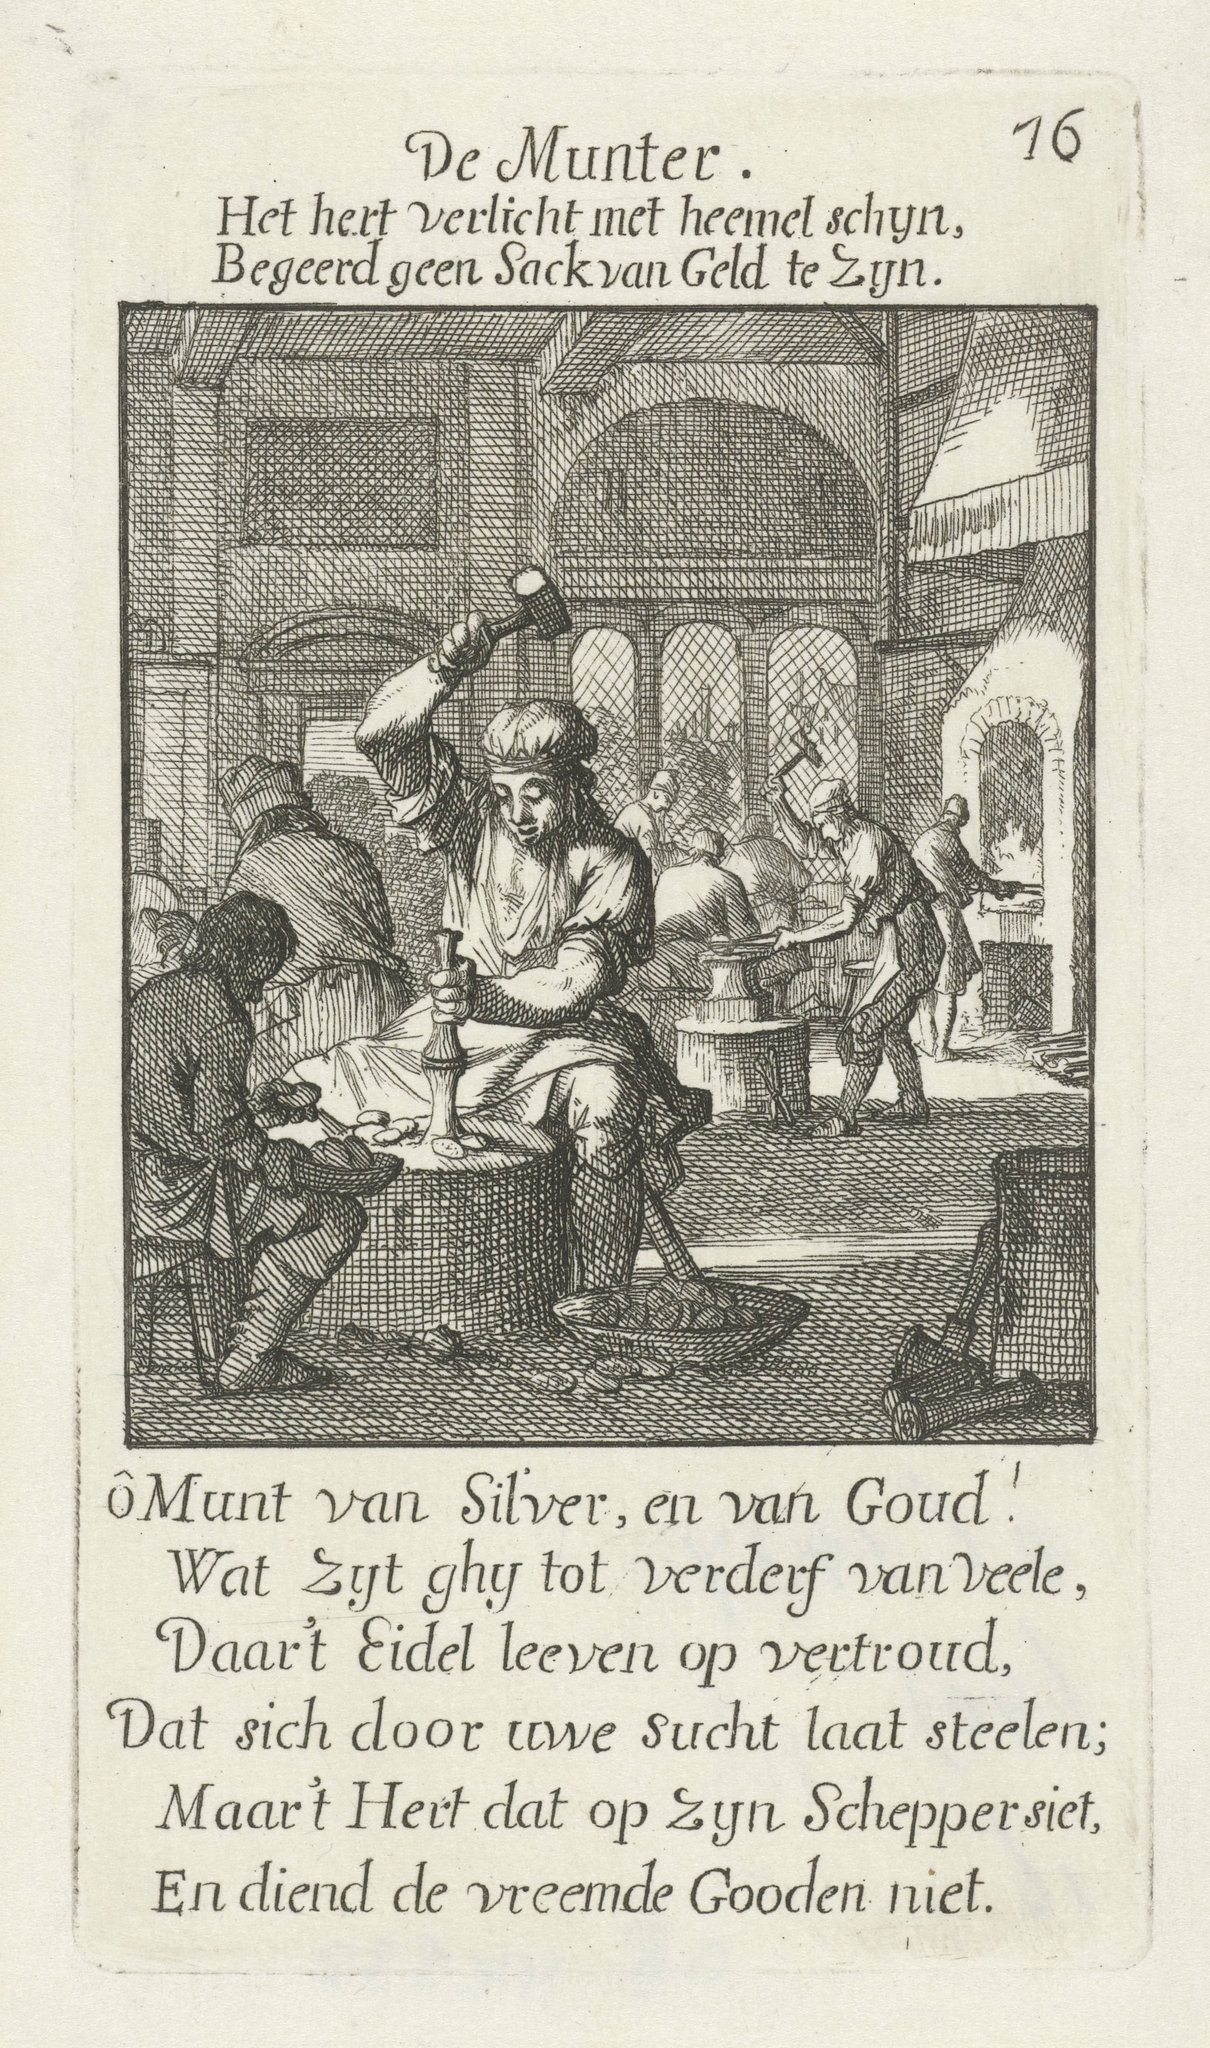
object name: print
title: Munter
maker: jan luyken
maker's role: draughtsman, print maker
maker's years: 1649-1712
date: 1694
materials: paper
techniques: etching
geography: amsterdam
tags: handicrafts, craftsman at work, minter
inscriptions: collector's mark: Lugt 2228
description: Maakt deel uit van de 100-delige serie beroepsprenten van Jan en Caspar Luyken, getiteld: Het menselyk bedryf. S.l.s.n., 1694 (eerste druk).